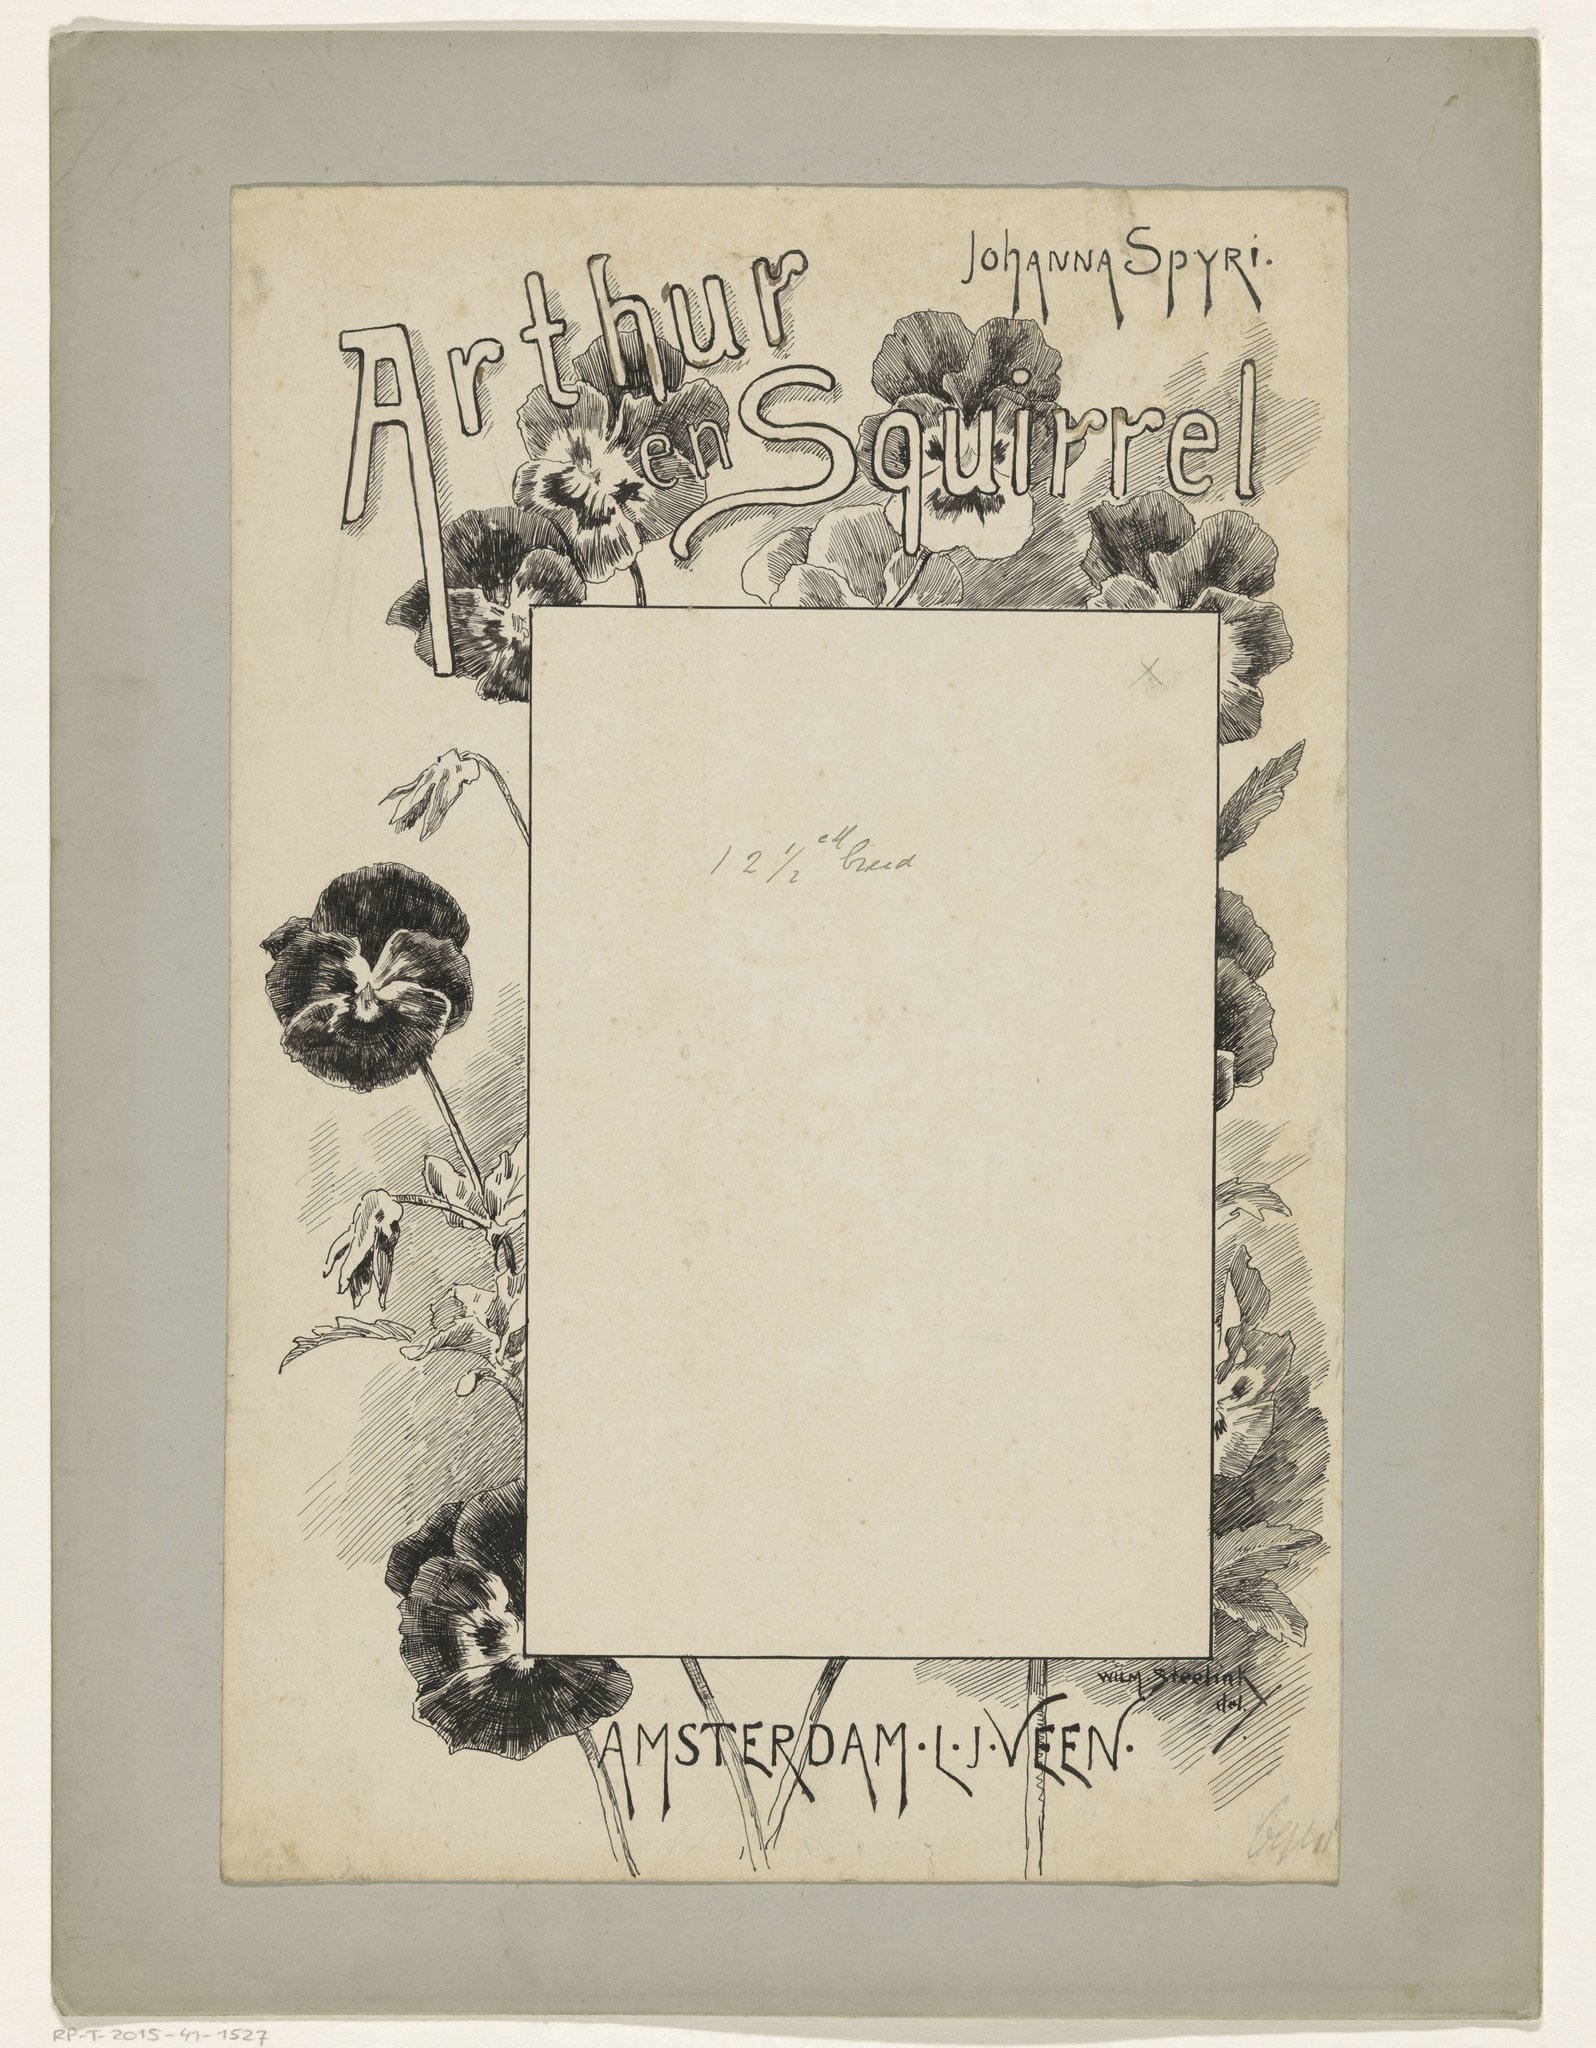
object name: drawing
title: Bandontwerp voor: Johanna Spyri, Arthur en Squirrel, c. 1888-1893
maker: willem steelink (ii)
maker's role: draughtsman, print maker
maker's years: 1856-1928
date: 1888-1893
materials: cardboard, ink, paper, pencil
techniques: pen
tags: flowers: violet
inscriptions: collector's mark: Lugt 2228, :, annotation: ‘pag 389’, signature: ‘WILM. Steelink/ del.’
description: Leeg kader met op de achtergrond viooltjes.